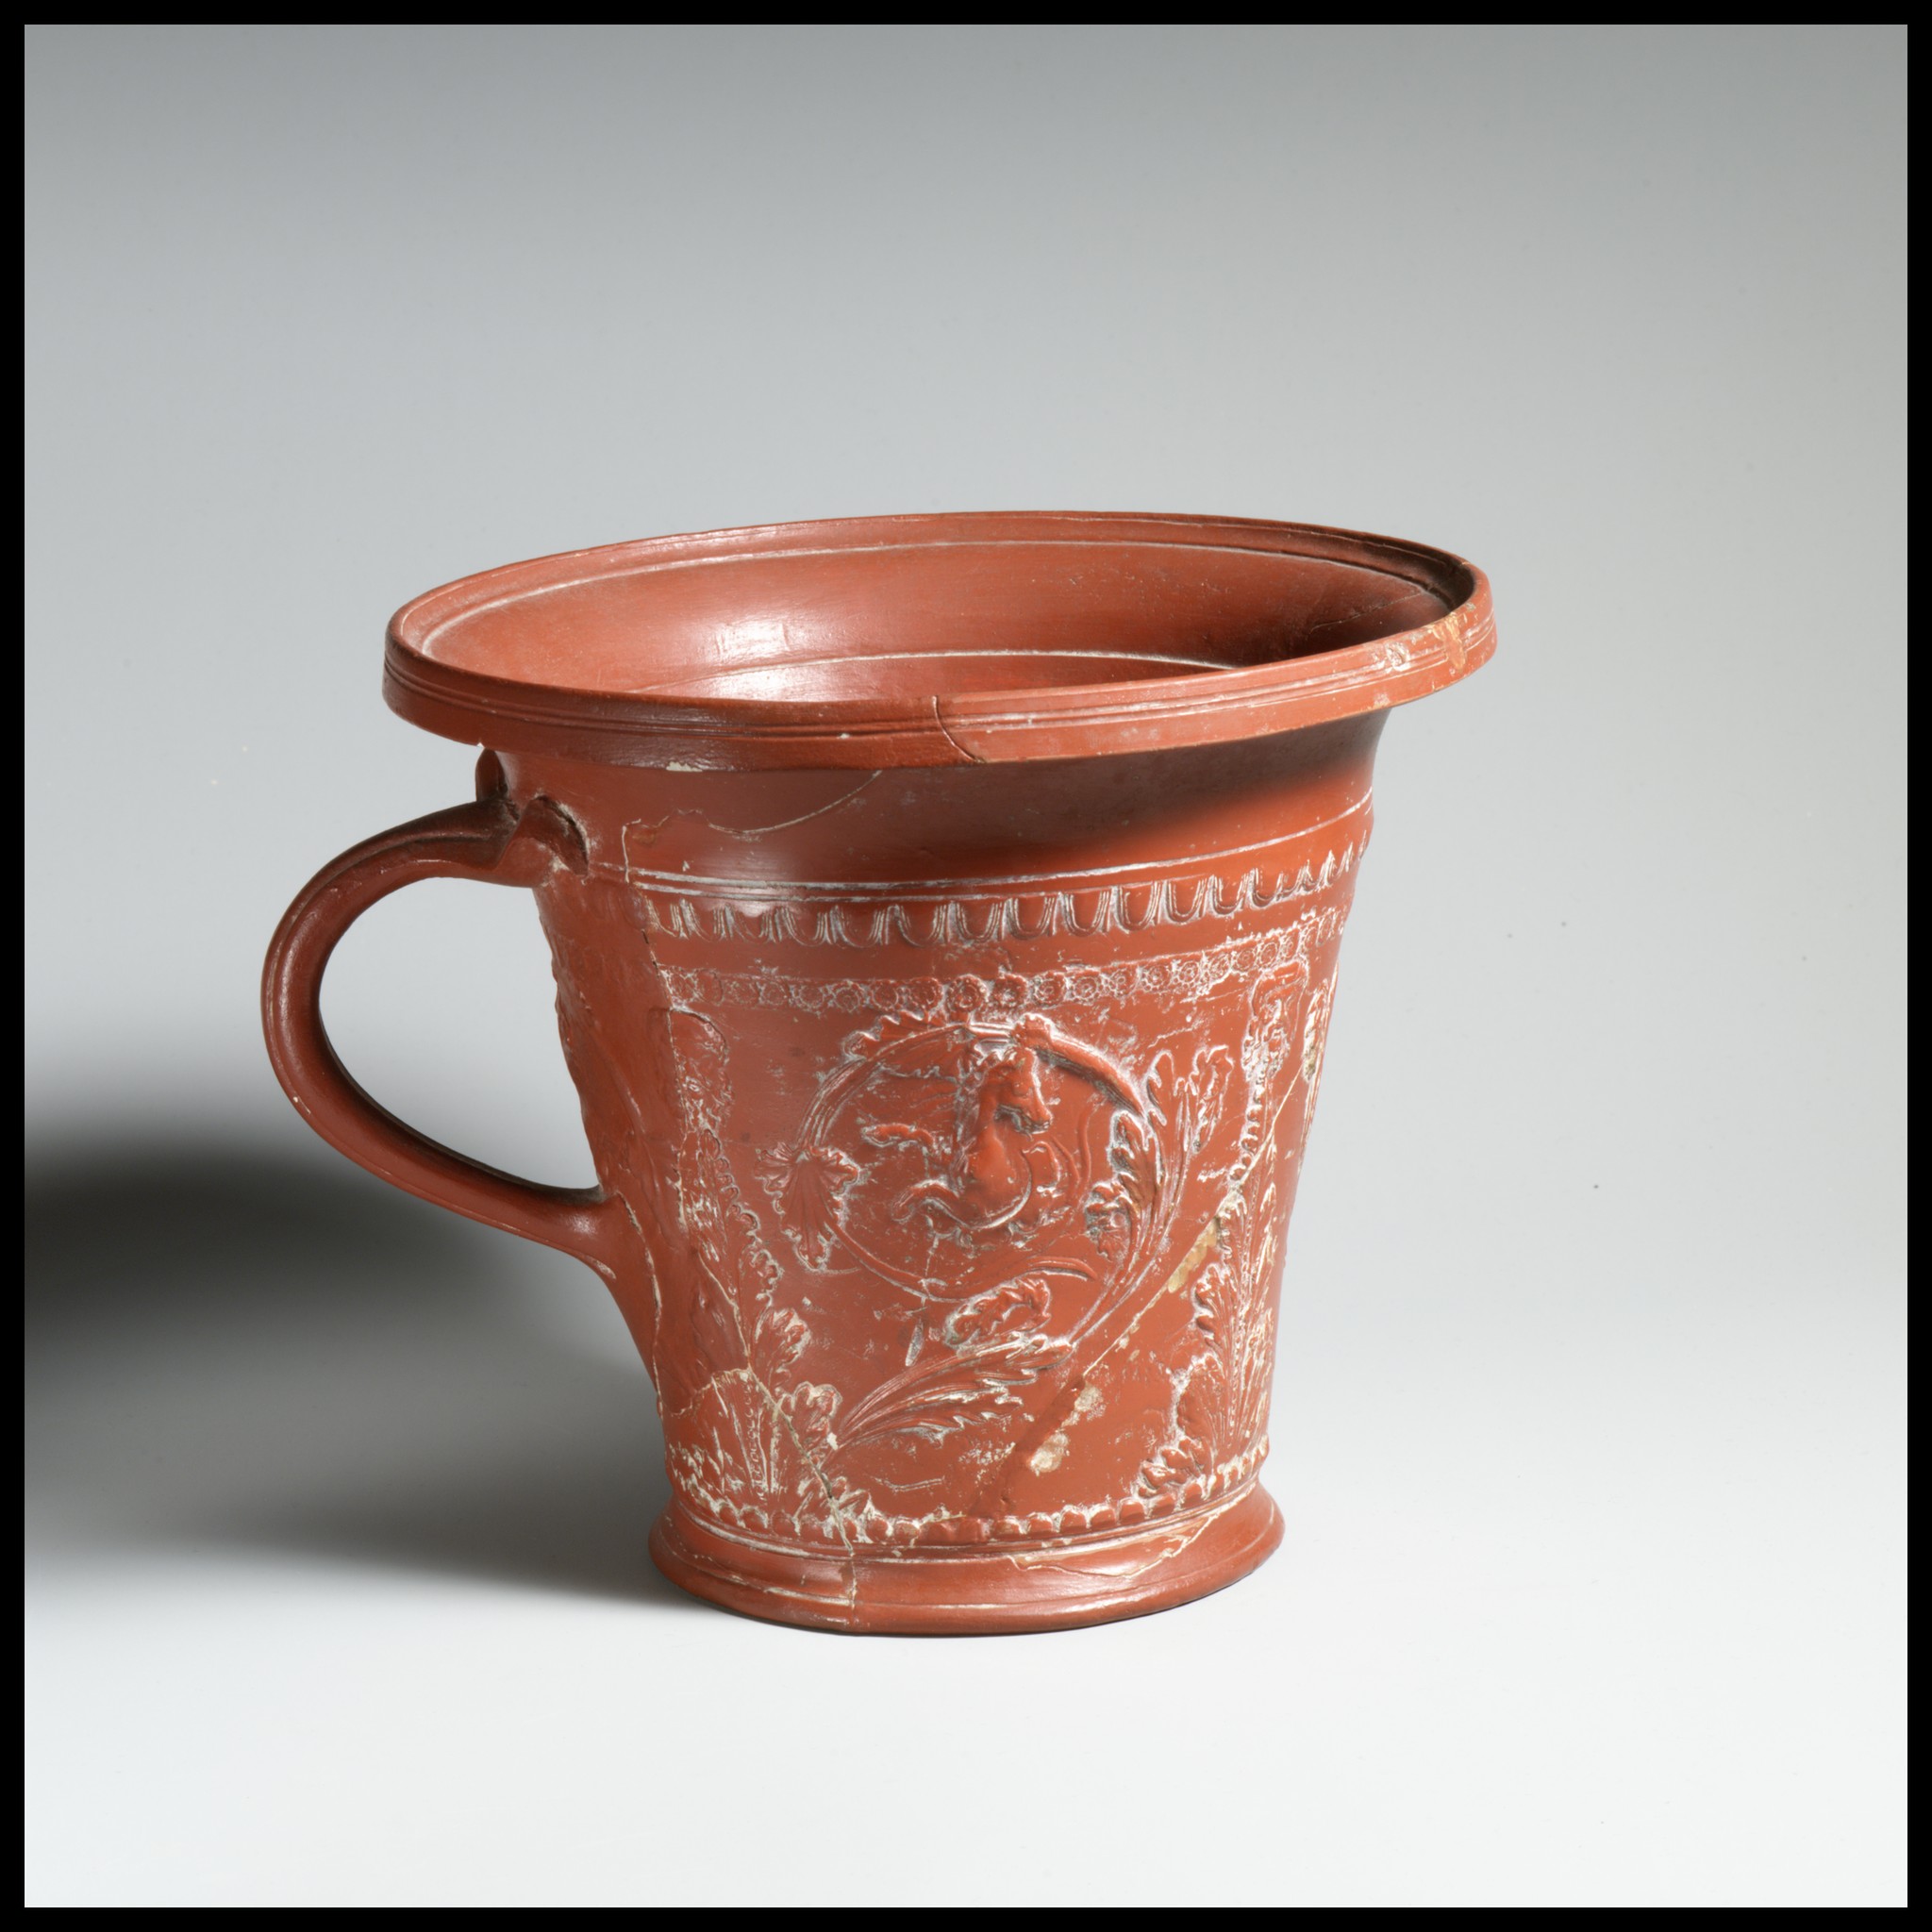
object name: cup, modiolus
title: Terracotta modiolus (drinking cup)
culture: roman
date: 5-40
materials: terracotta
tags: masks,horses